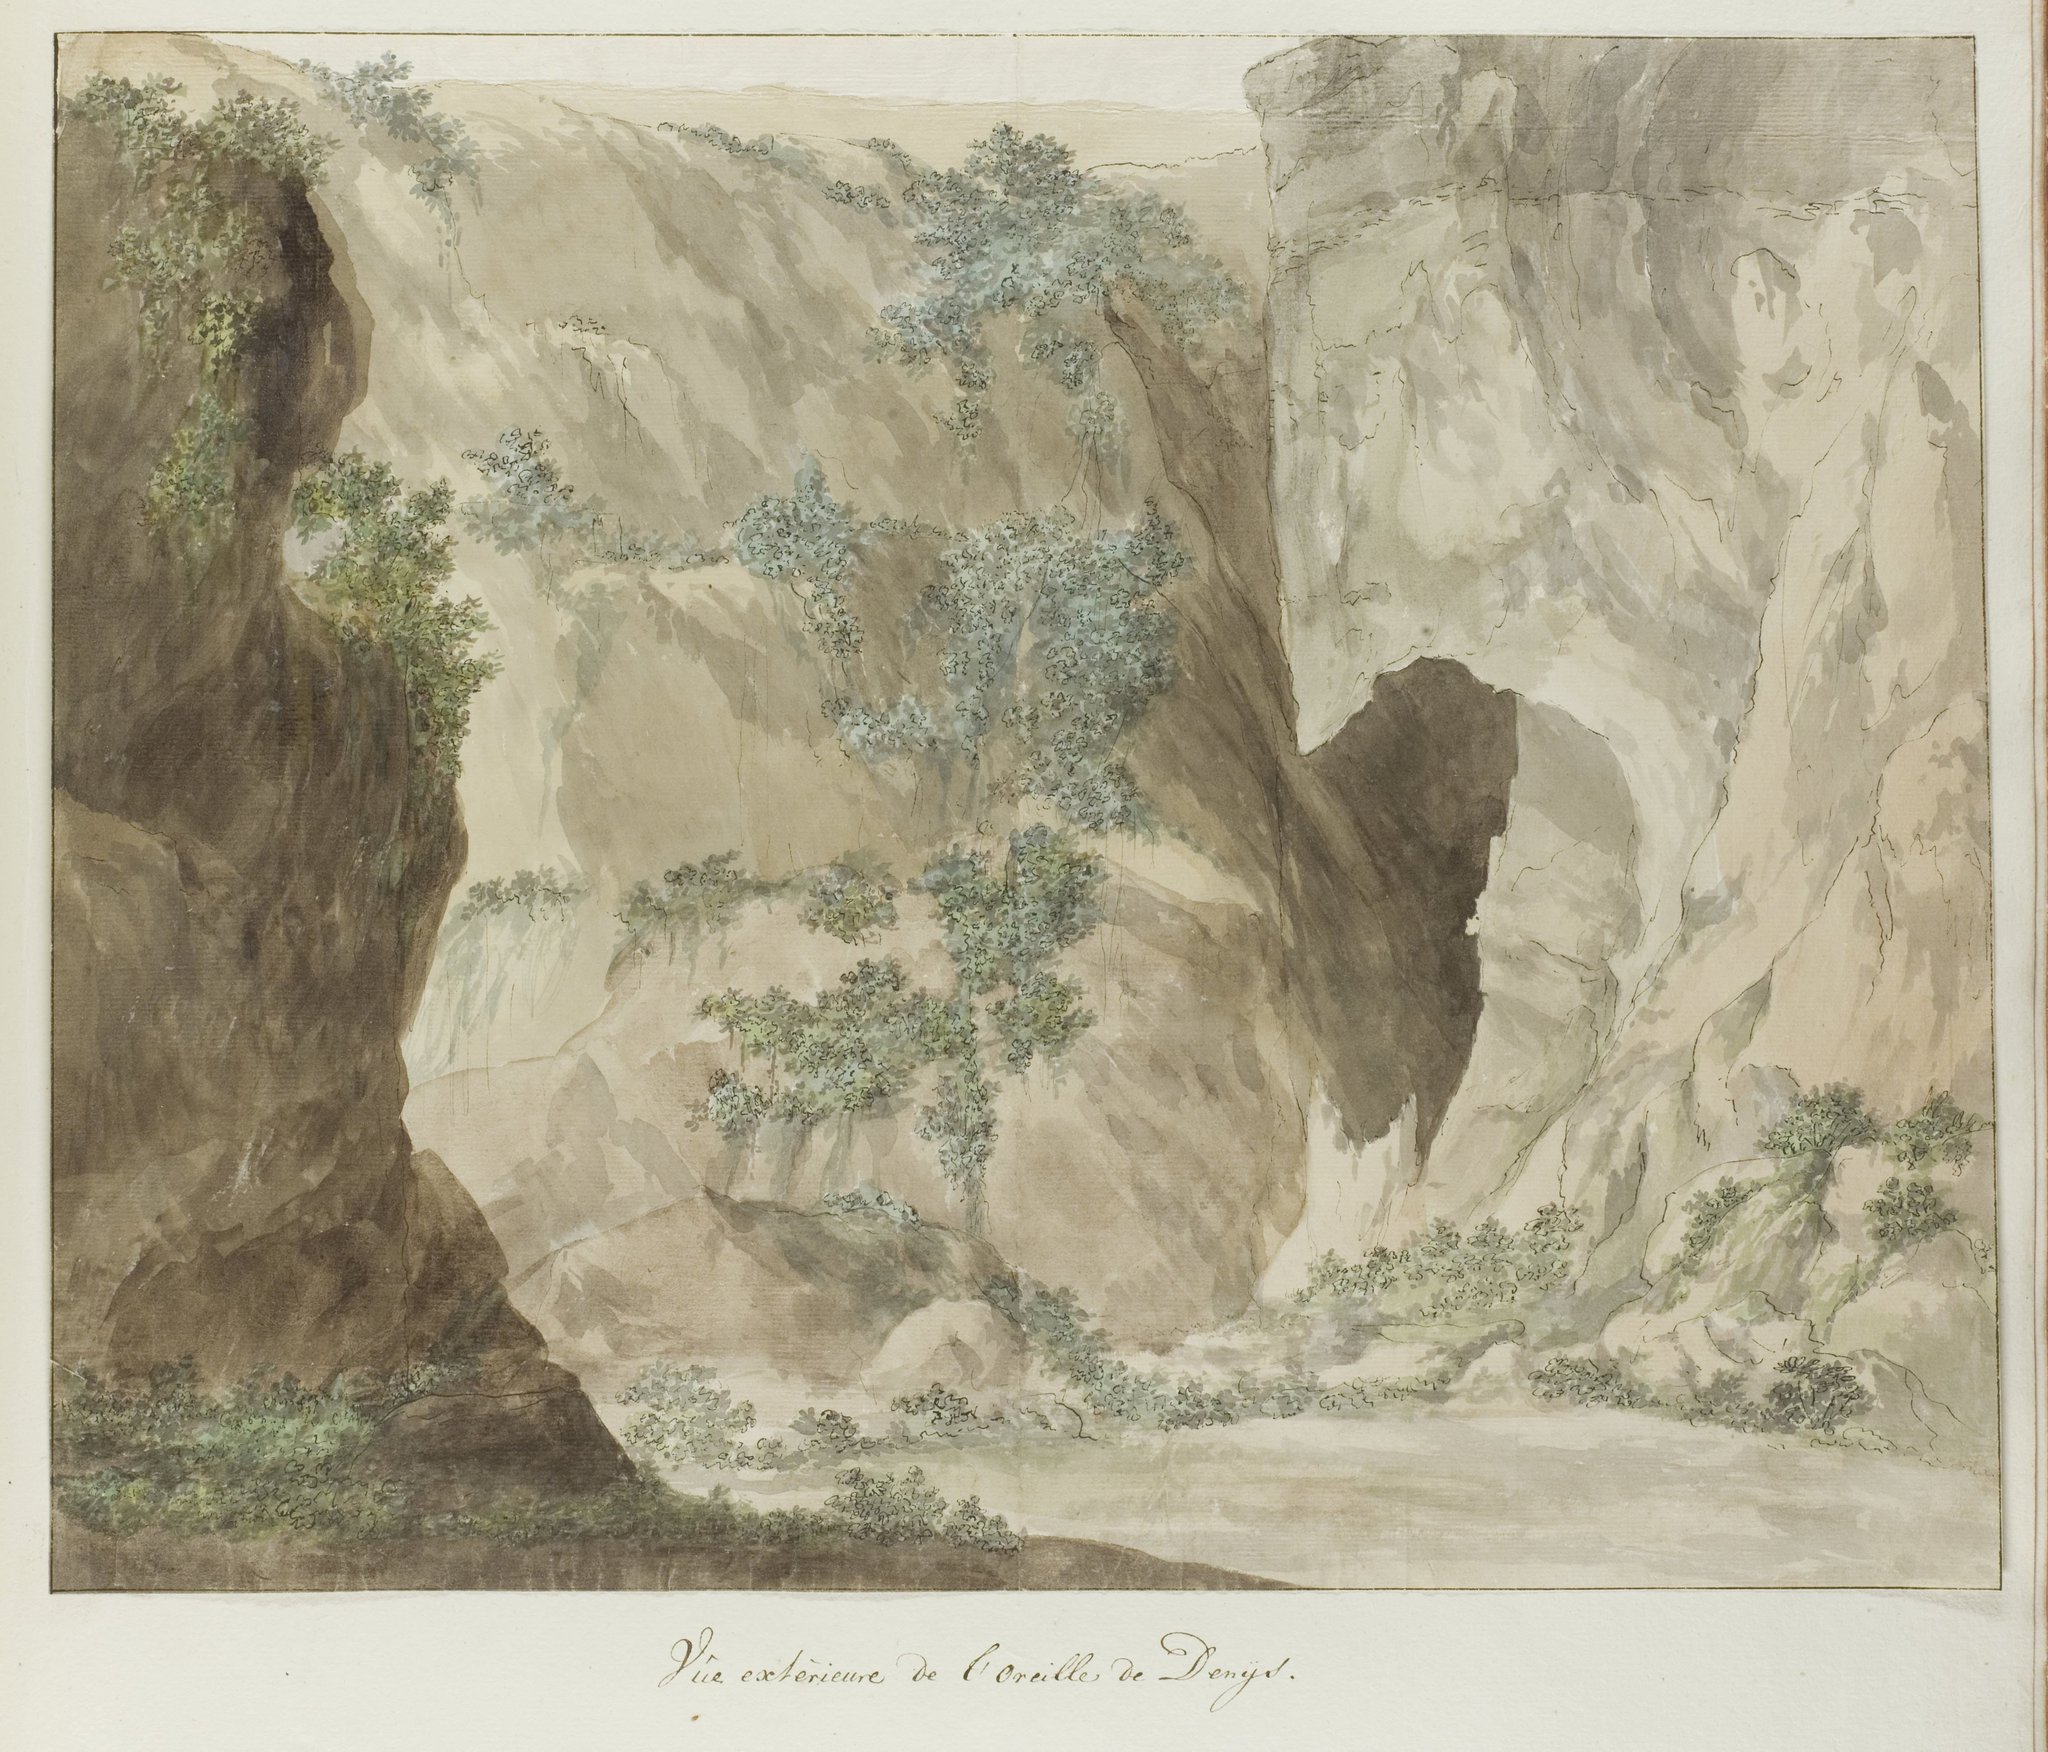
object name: drawing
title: Voyage en Italie, en Sicile et à Malte - 1778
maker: louis ducros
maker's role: draughtsman, print maker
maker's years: 1748-1810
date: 1778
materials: chalk, paper, watercolor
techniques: brush, pen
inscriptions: number: ‘No 187 Vue extérieure de l'Oreille de Denys’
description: Tekening uit het album 'Voyage en Italie, en Sicile et à Malte', 1778.